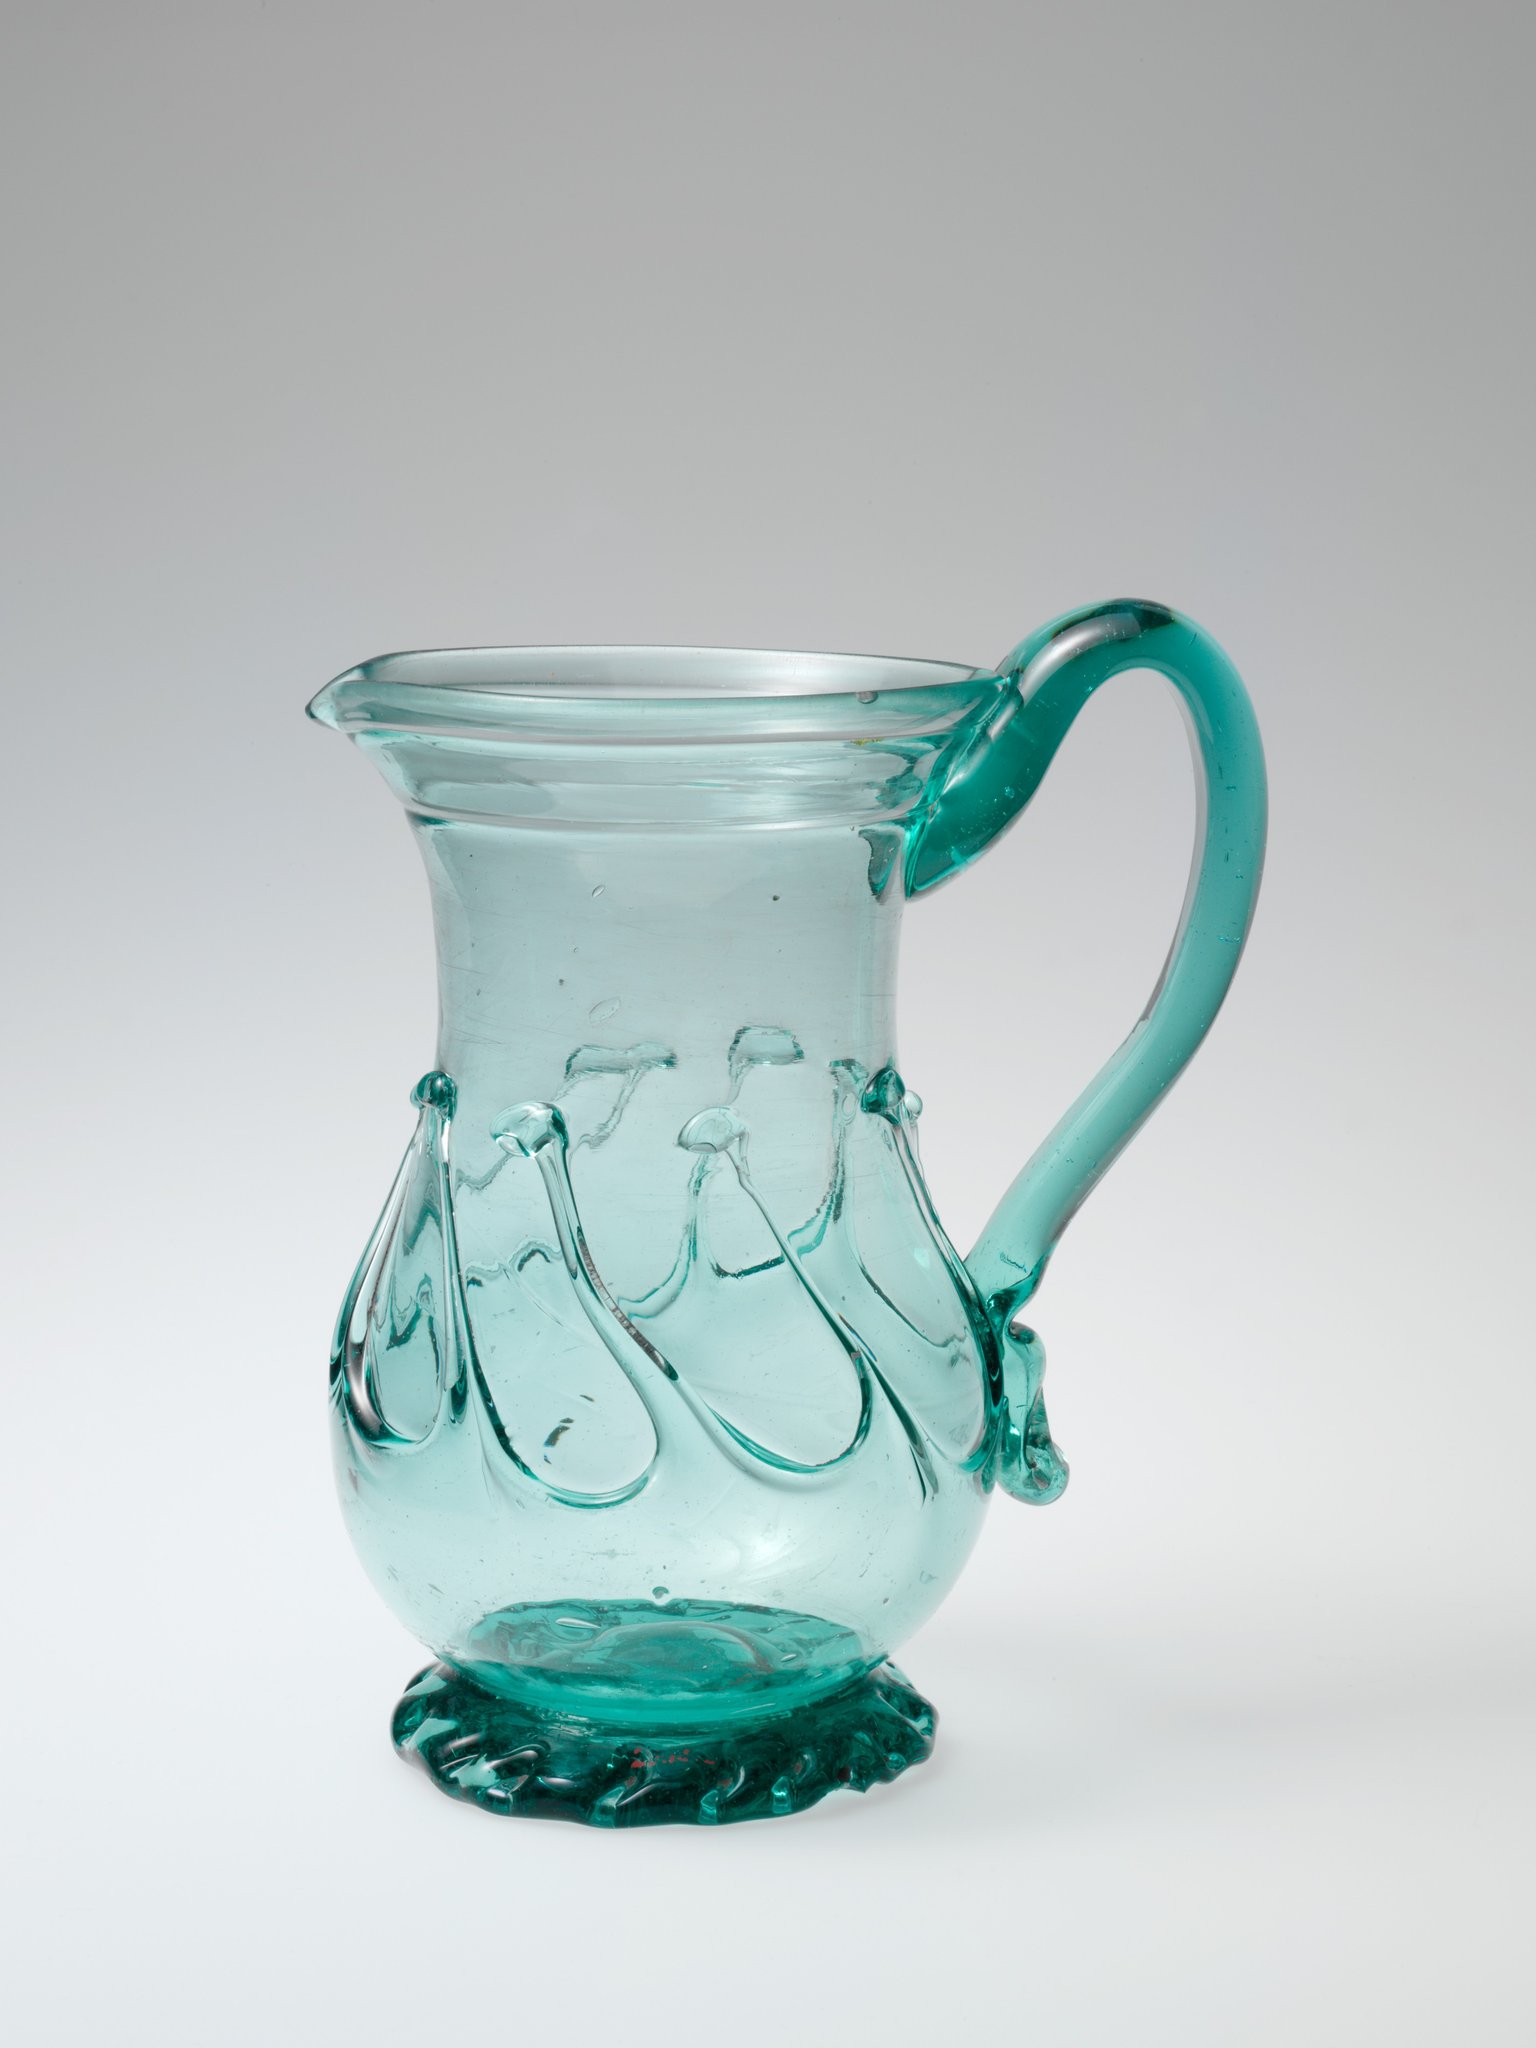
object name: pitcher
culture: american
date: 1835-1865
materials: glass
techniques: glassblowing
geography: united states